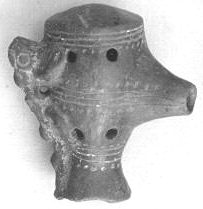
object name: pottery whistle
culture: costa rican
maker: linea vieja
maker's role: maker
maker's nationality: costa rican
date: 800-1525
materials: clay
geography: costa rica